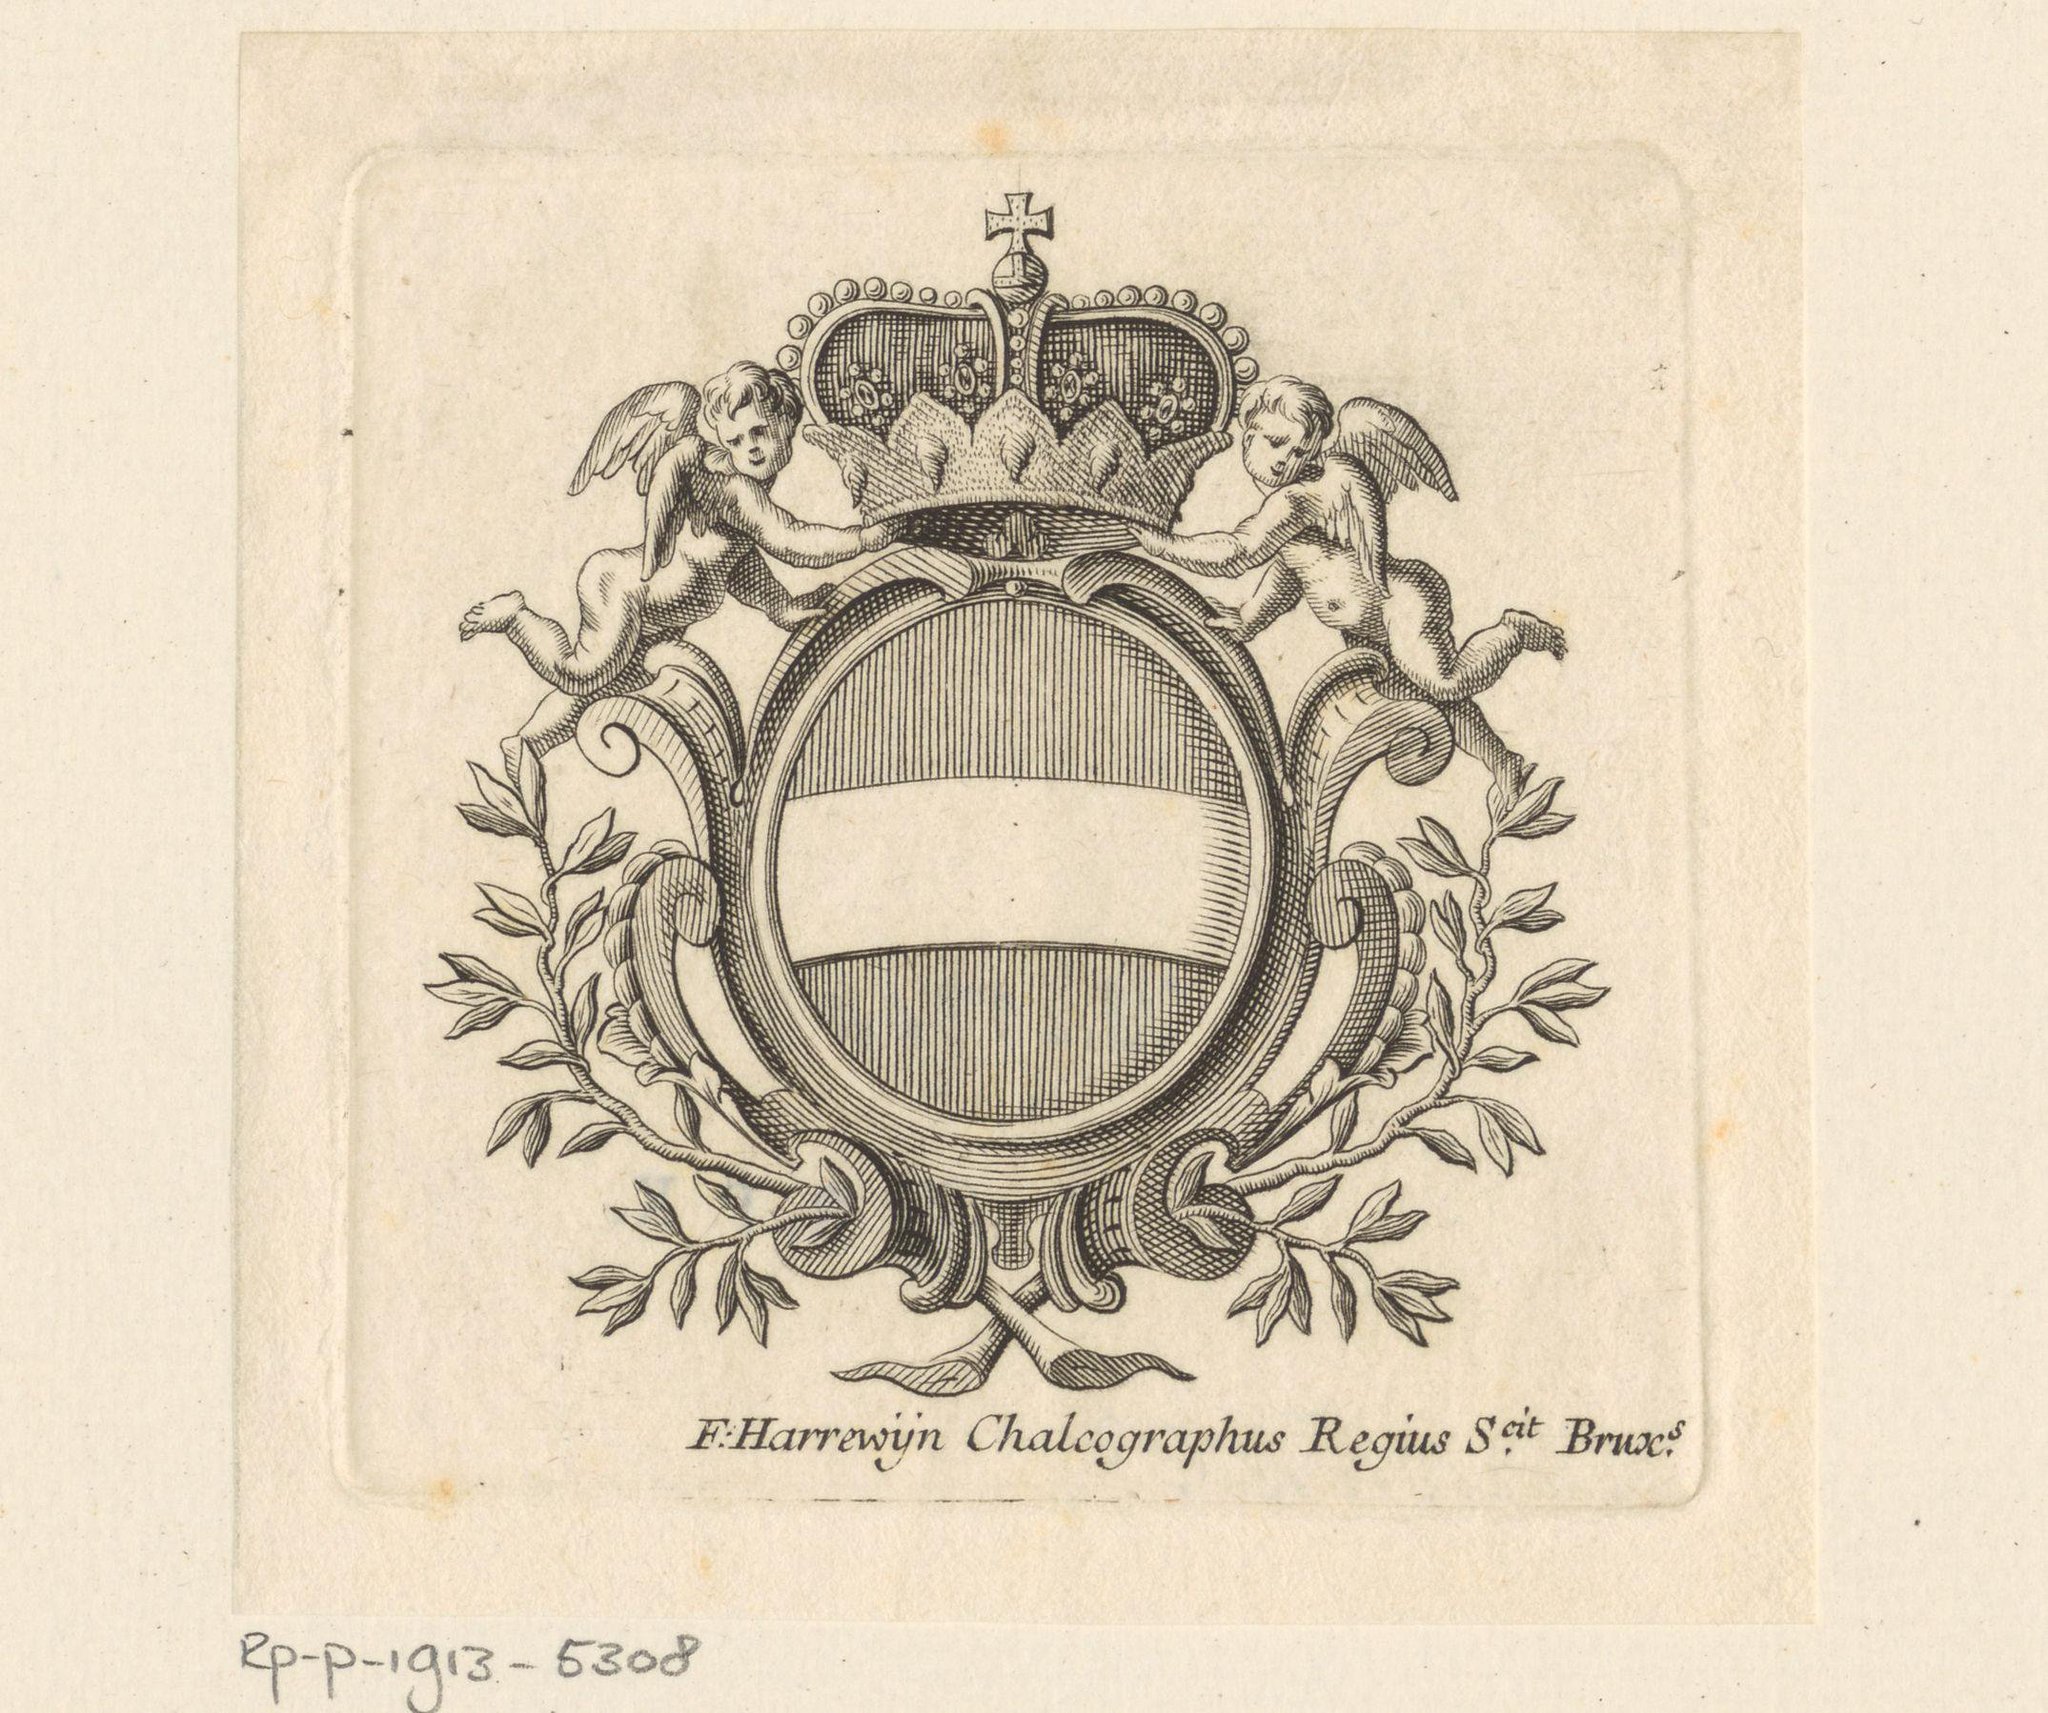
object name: bookplate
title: Ex libris van onbekend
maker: françois harrewijn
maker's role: print maker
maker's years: 1700-1764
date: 1710-1764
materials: paper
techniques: engraving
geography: brussels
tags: armorial bearing, heraldry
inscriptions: collector's mark: Lugt 2233, collector's mark: Lugt 2760